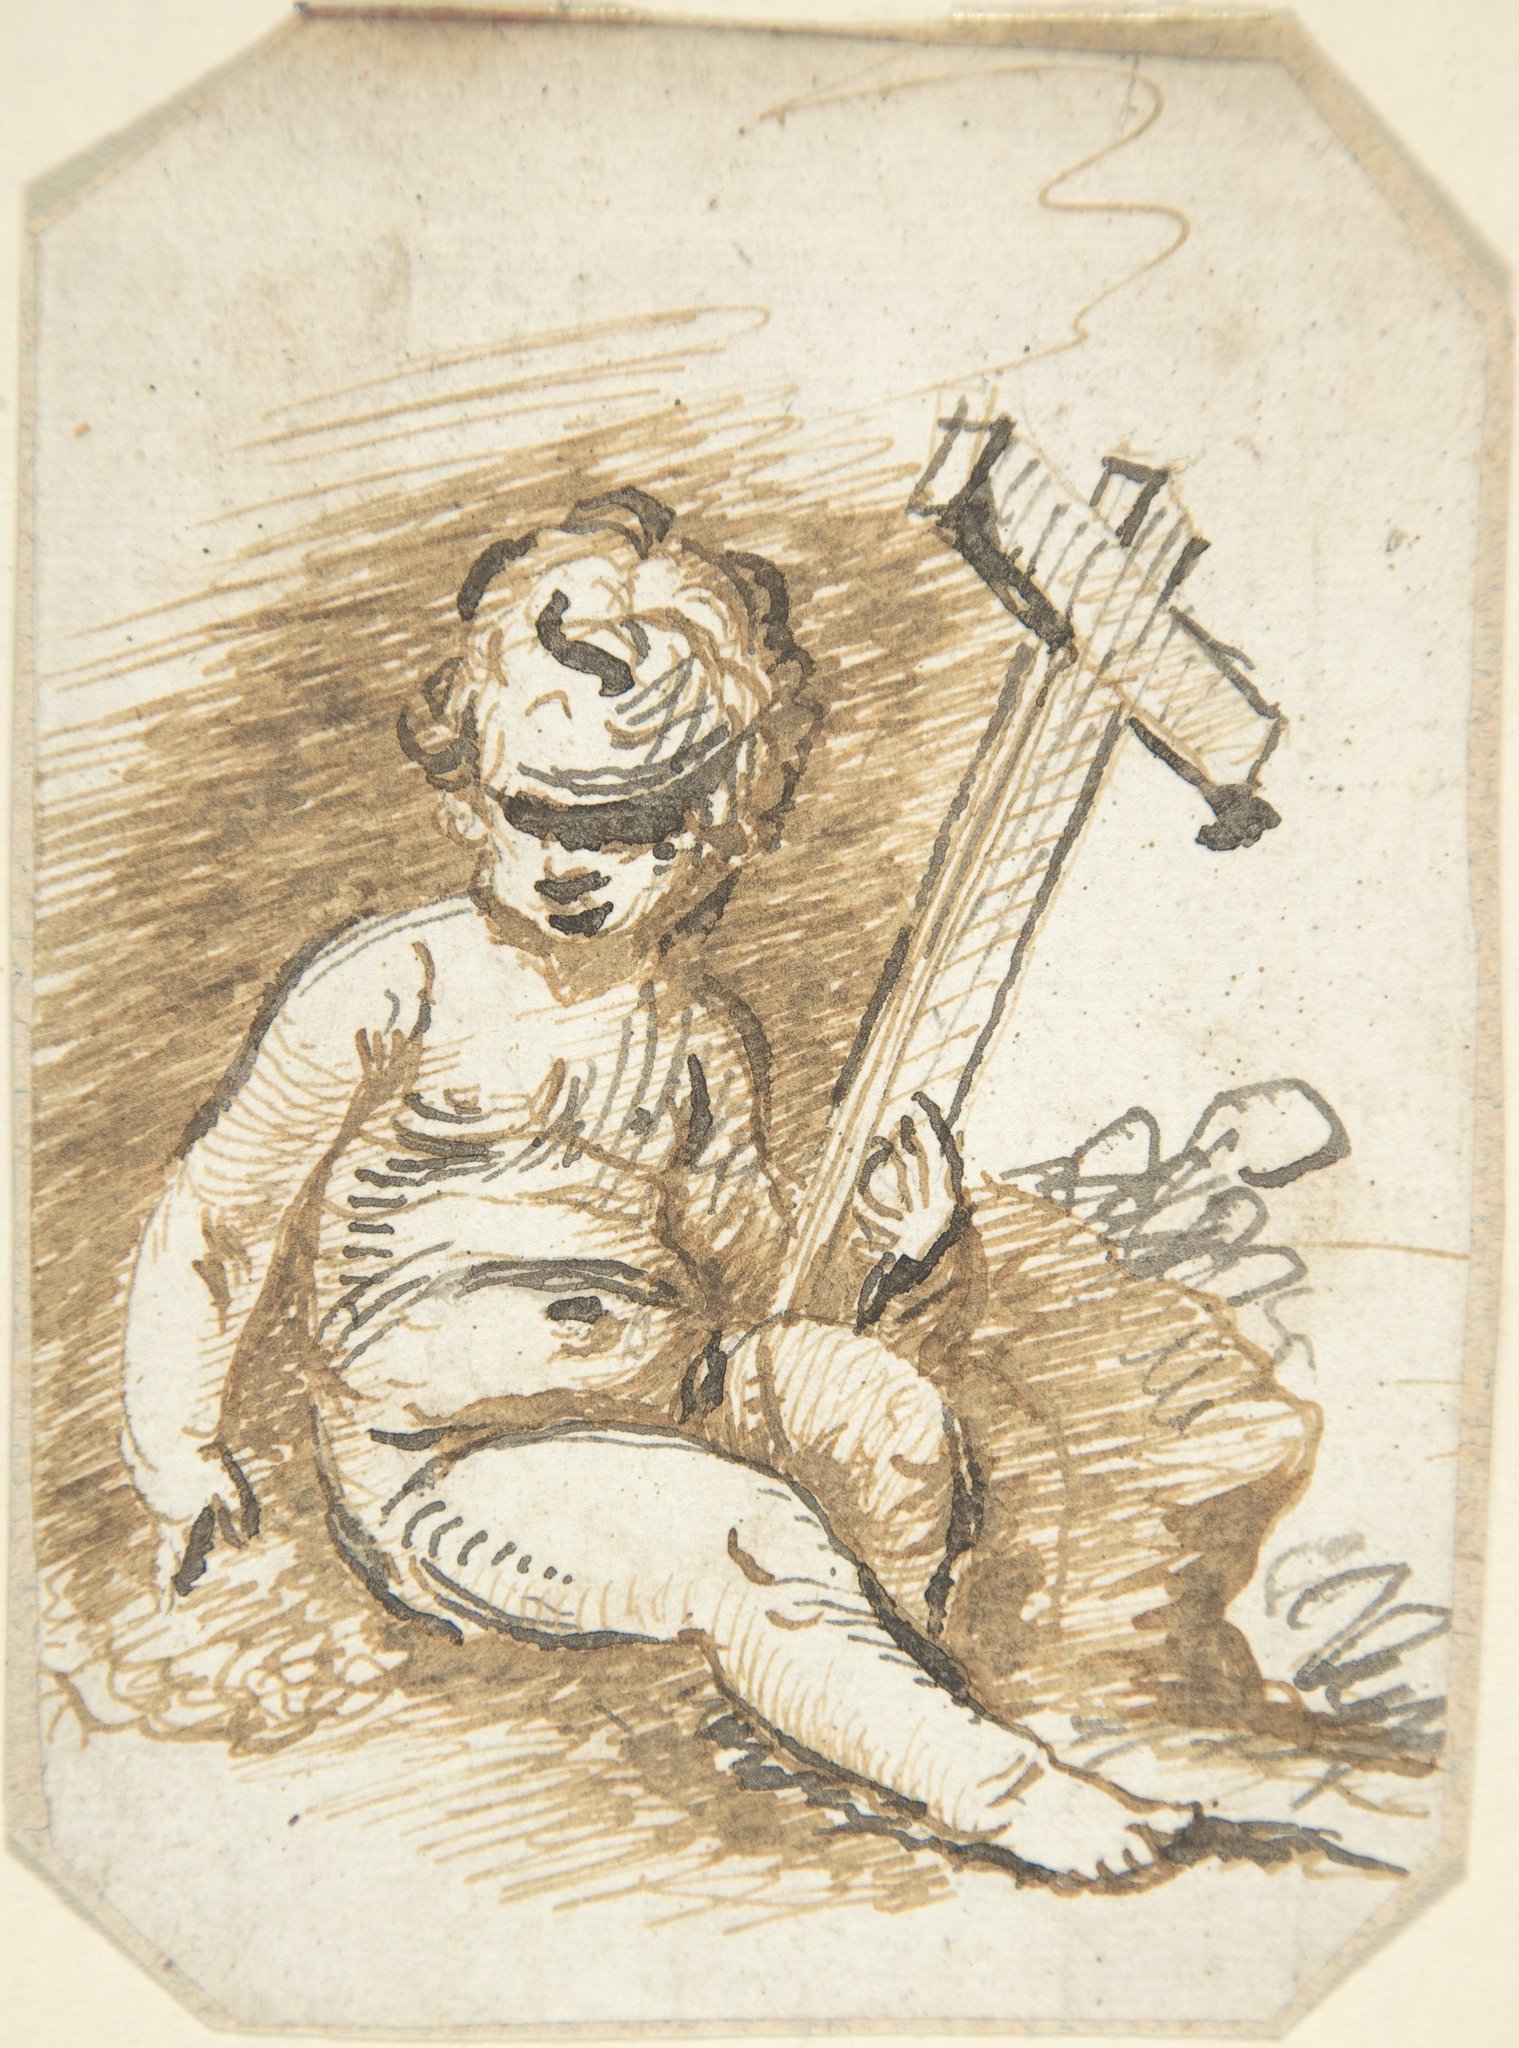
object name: drawing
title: Infant Christ with the Cross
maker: anonymous, spanish, school of seville, 17th century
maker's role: artist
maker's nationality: spanish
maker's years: 1600-1700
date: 1601-1700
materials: ink, paper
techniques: pen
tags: christ,cross